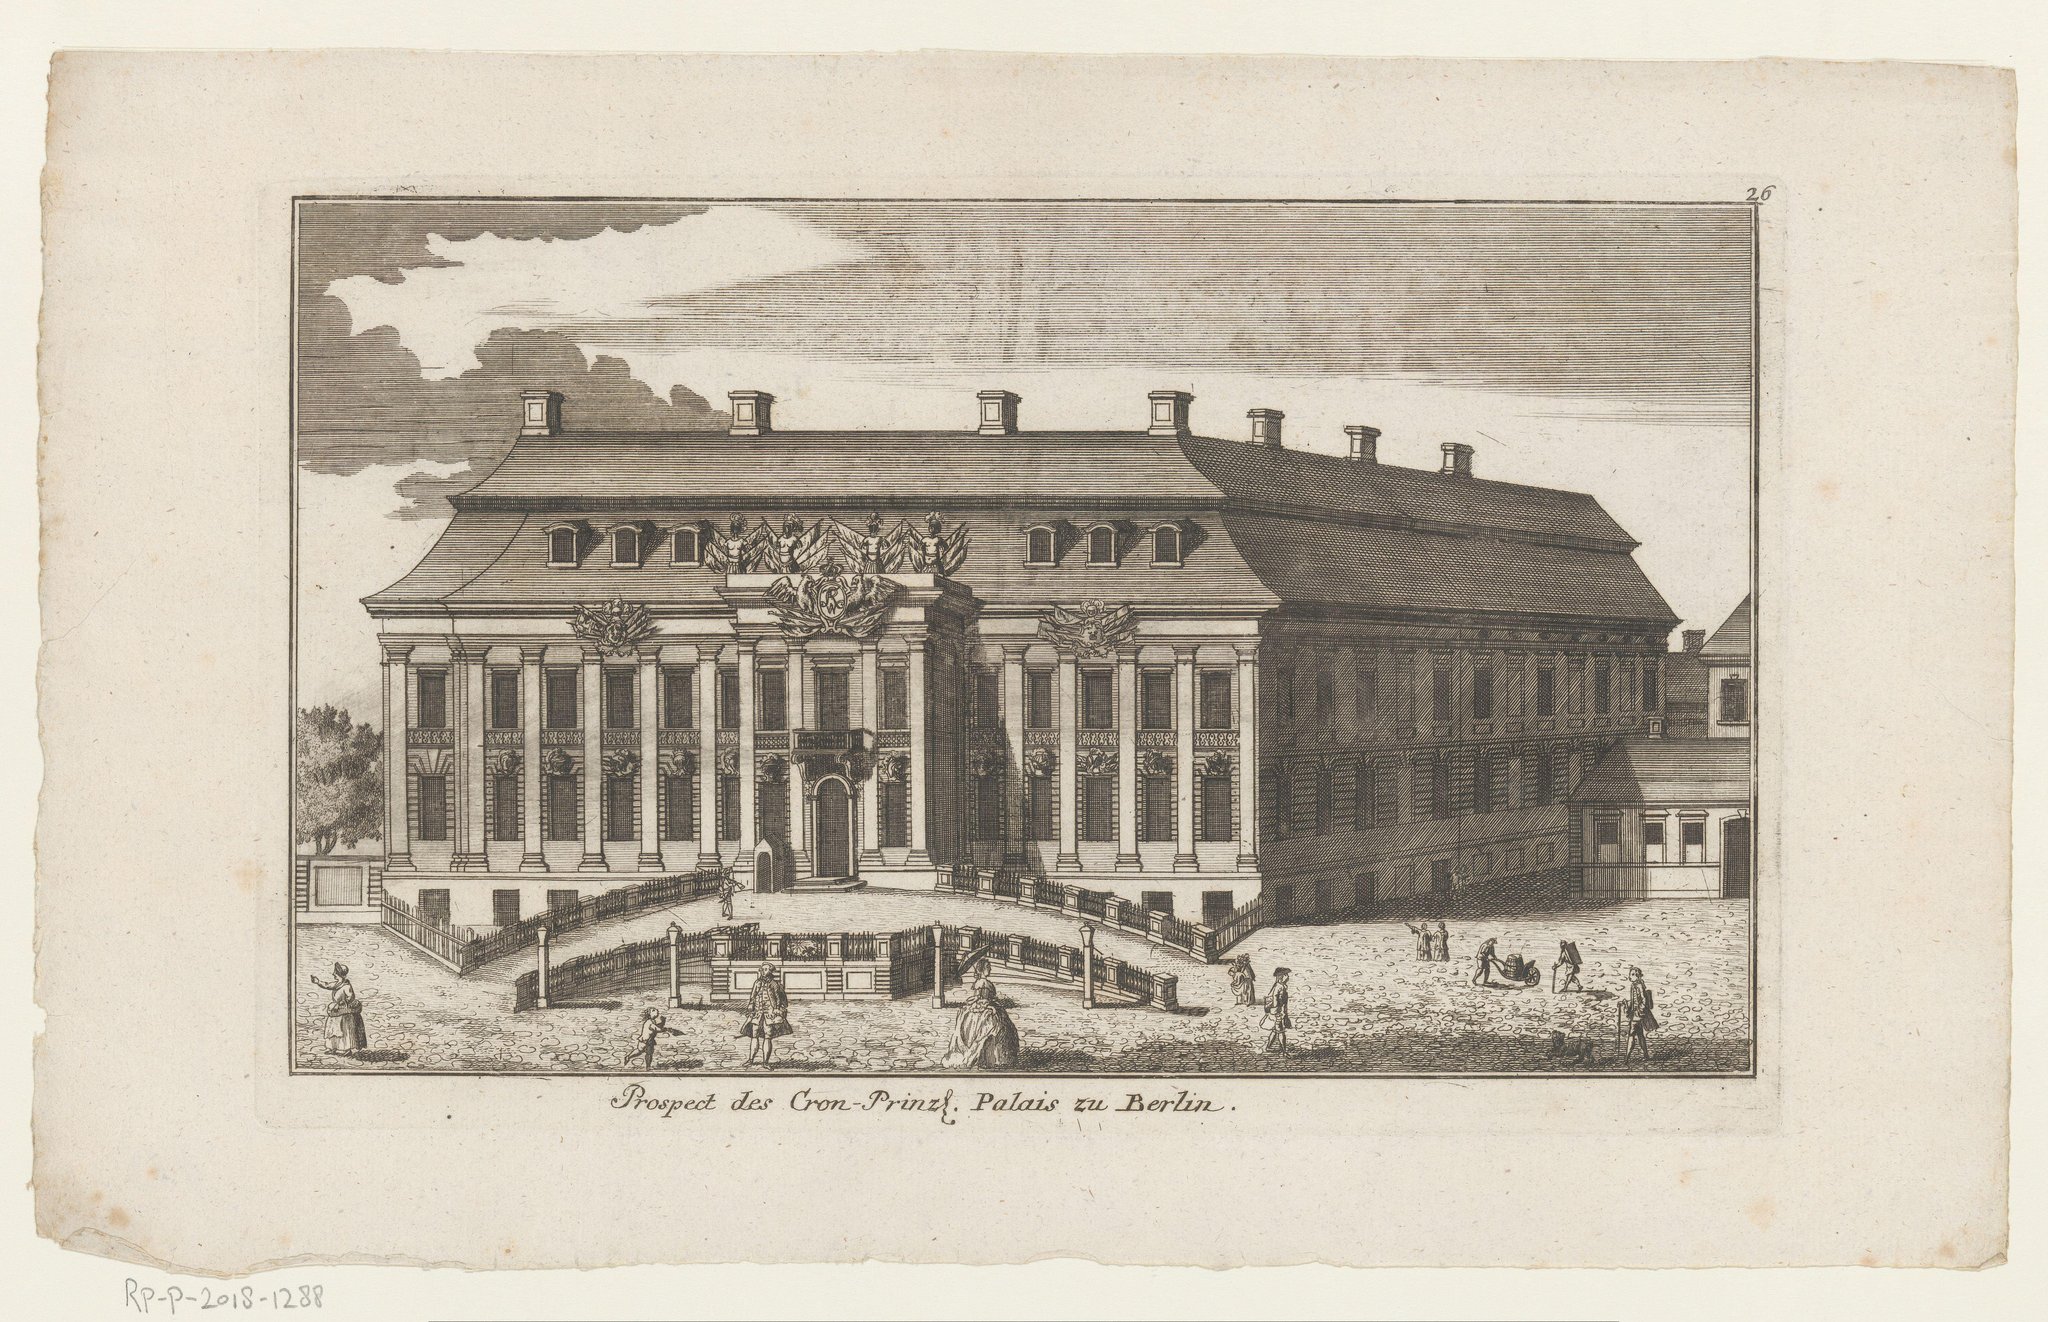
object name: print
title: Gezicht op het Kronprinzenpalais, te Berlijn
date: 1740-1774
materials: paper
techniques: engraving, etching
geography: berlin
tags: palace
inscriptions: collector's mark: Lugt 2228